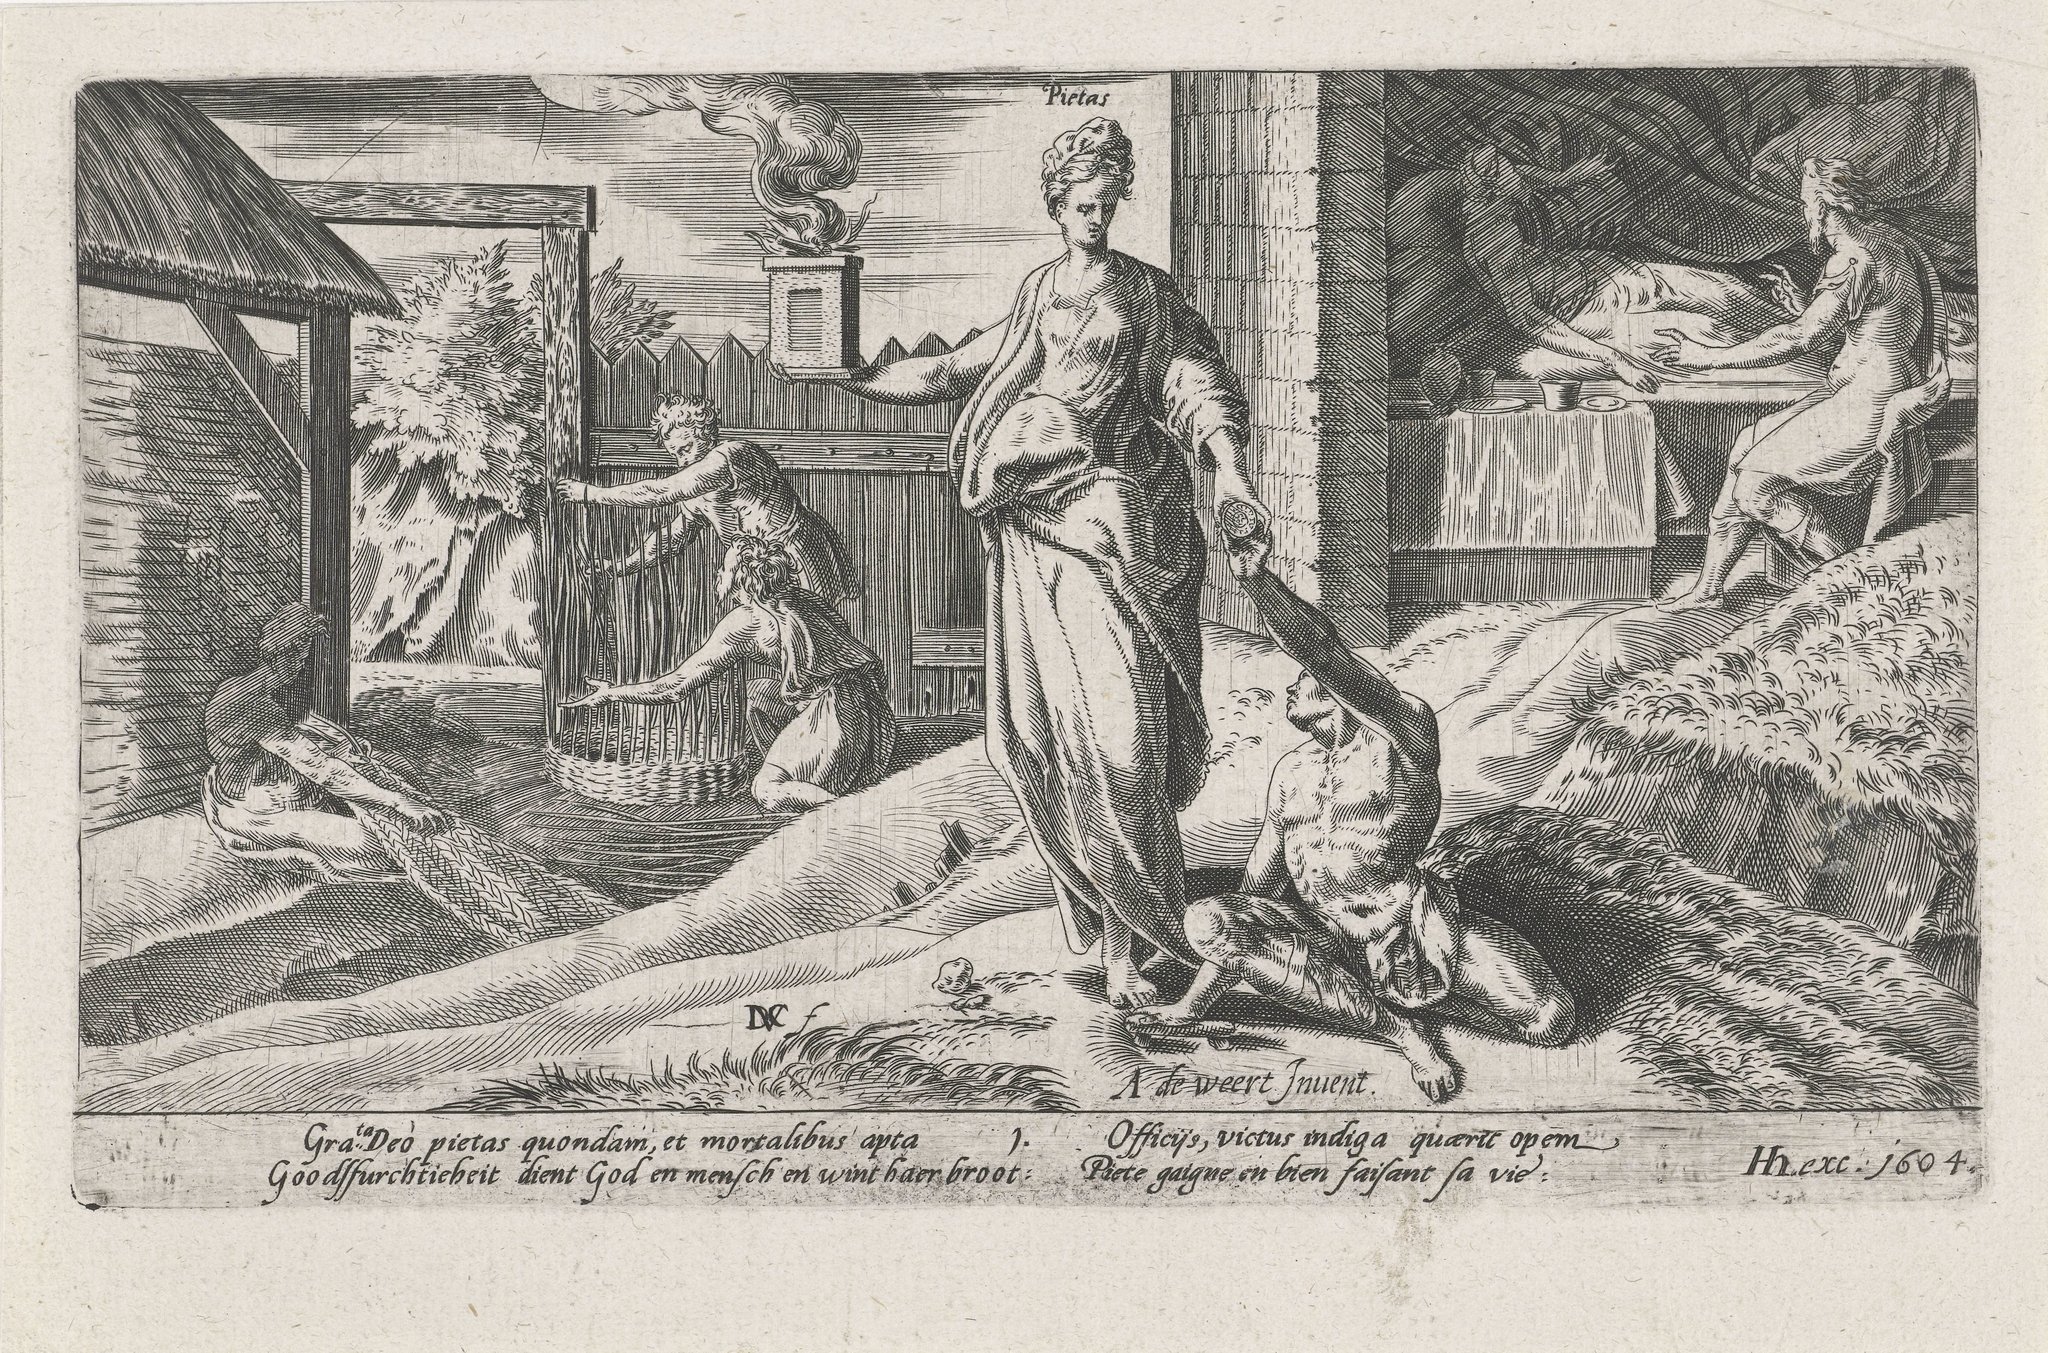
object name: print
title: Uit godsvruchtigheid doet de mens zijn plicht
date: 1604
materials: paper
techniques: engraving, etching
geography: cologne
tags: giving alms or other charity, e.g.: handing out food, craft-production, skilled handiwork, visiting the sick, 'aeger curatur' ~ one of the (seven) acts of mercy, piety, 'pietas', 'timor dei' ~ the three theological virtues, low countries, beeldenstorm (1566)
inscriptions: collector's mark: Lugt 2228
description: De personificatie van Vroomheid (Pietas) geeft een bedelaar een aalmoes. Als attribuut houdt ze een brandend altaar in de hand. In de achtergrond uitingen van godsvruchtig leven: ziekenbezoek als een van de werken van barmhartigheid (rechts) en de uitvoer van dagelijks werk zoals matten en manden vlechten. De prent heeft een Nederlands, Latijns en Frans onderschrift en maakt deel uit van een twaalfdelige serie met als onderwerp de ontaarding van de katholieke geestelijkheid en de oorzaken van de opstand en de beeldenstorm.